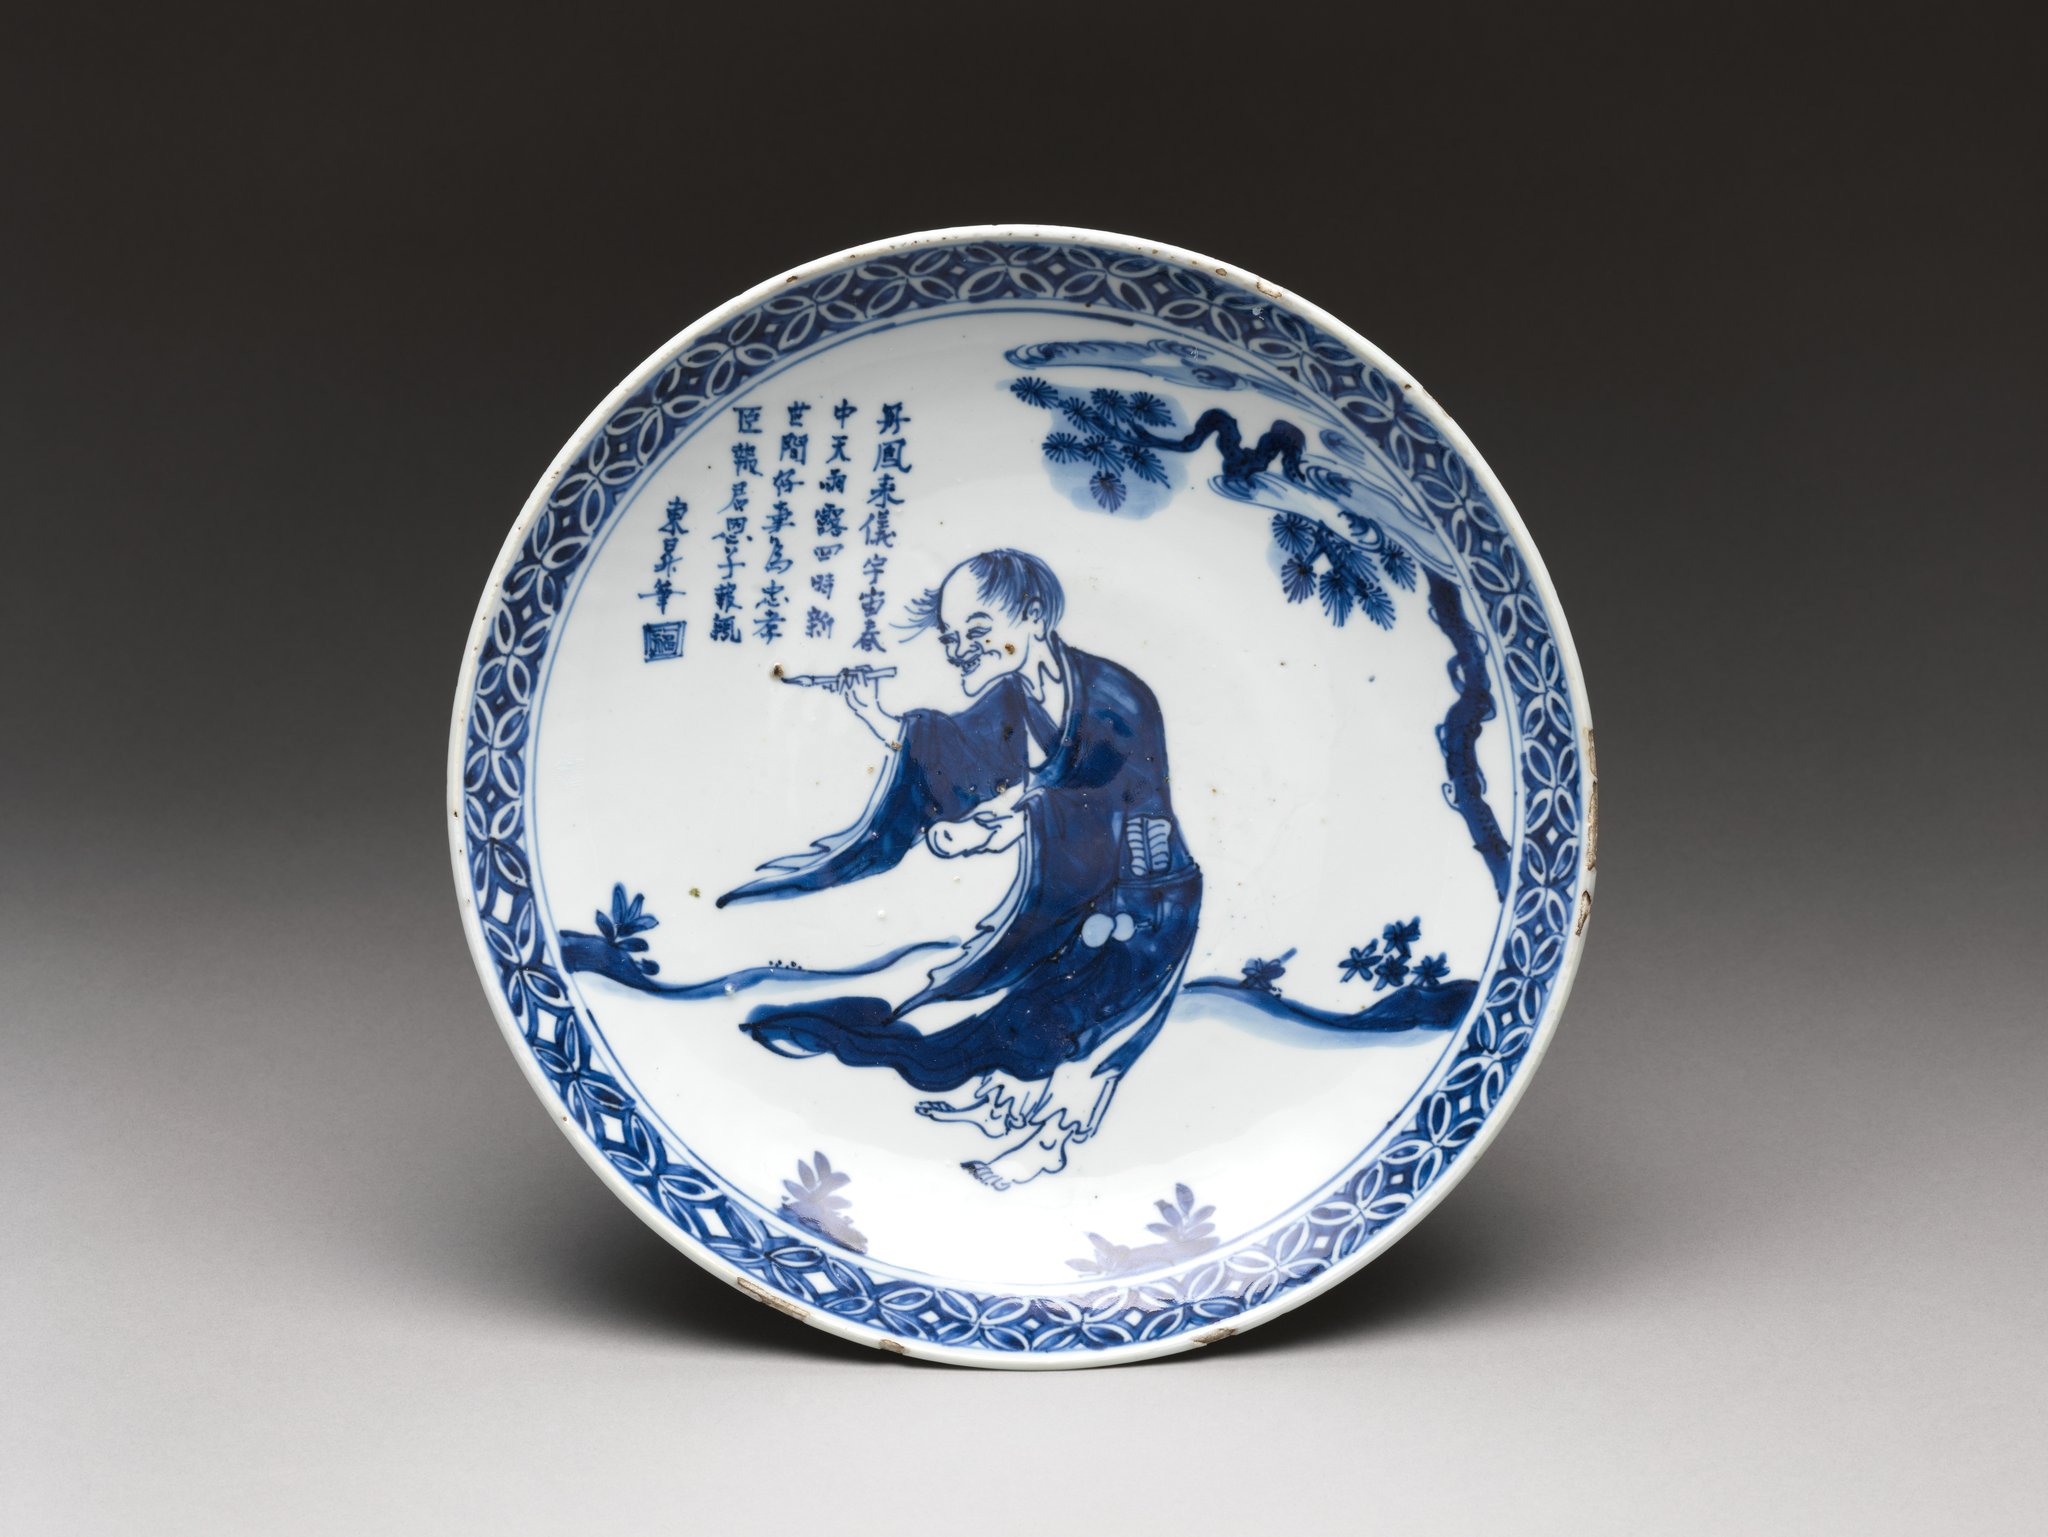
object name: dish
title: Dish with Buddhist Monk-Poet Hanshan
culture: chinese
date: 1634-1666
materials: cobalt, glaze, porcelain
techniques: painting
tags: men,buddhism,monks,poets